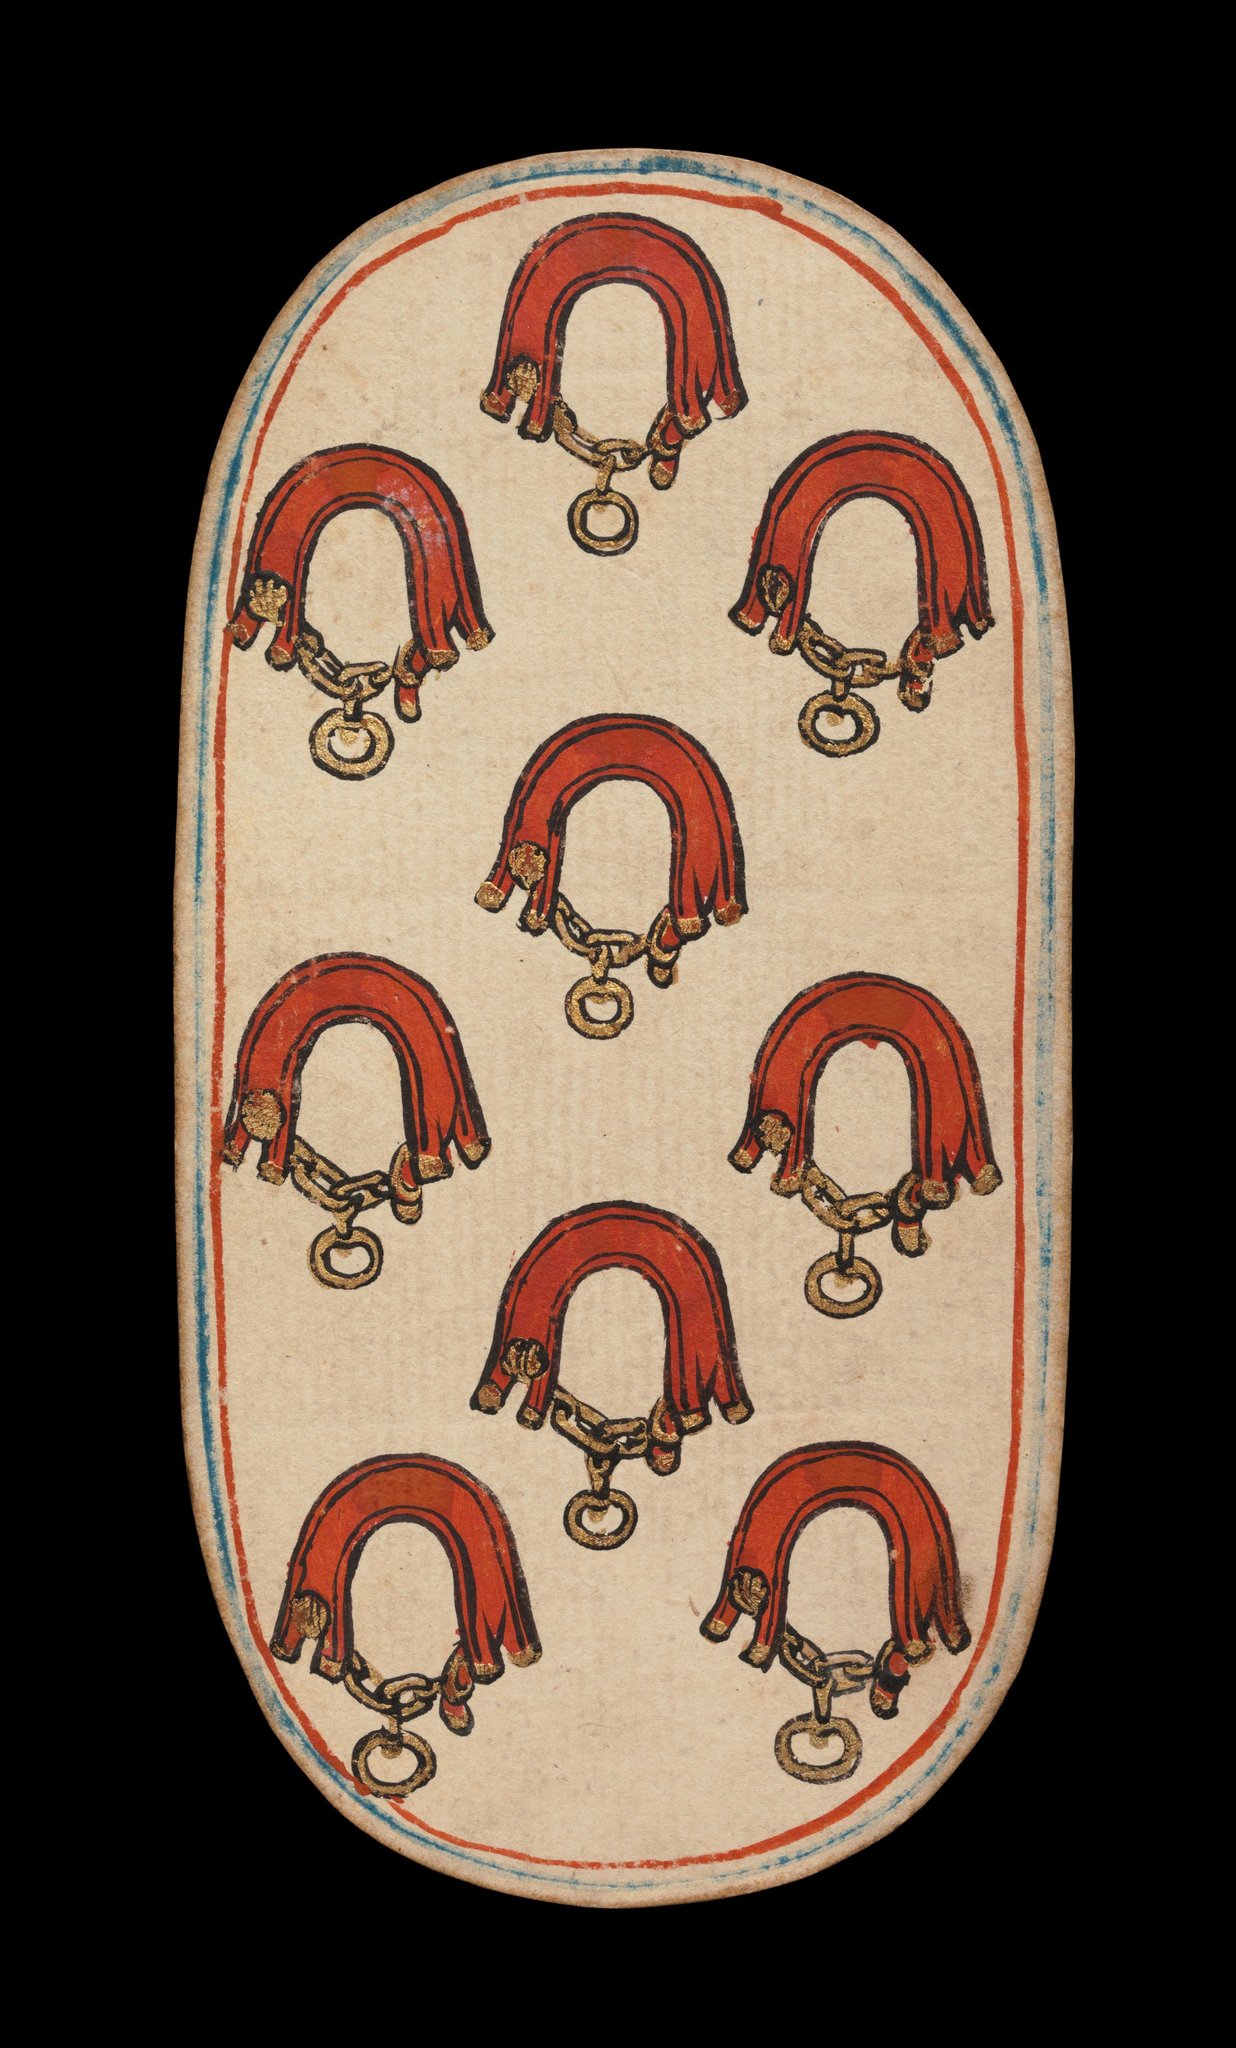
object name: playing card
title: 9 of Collars, from The Cloisters Playing Cards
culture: south netherlandish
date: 1475-1480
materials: glaze, gold, ink, paint, paper, silver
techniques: pen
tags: playing cards,games